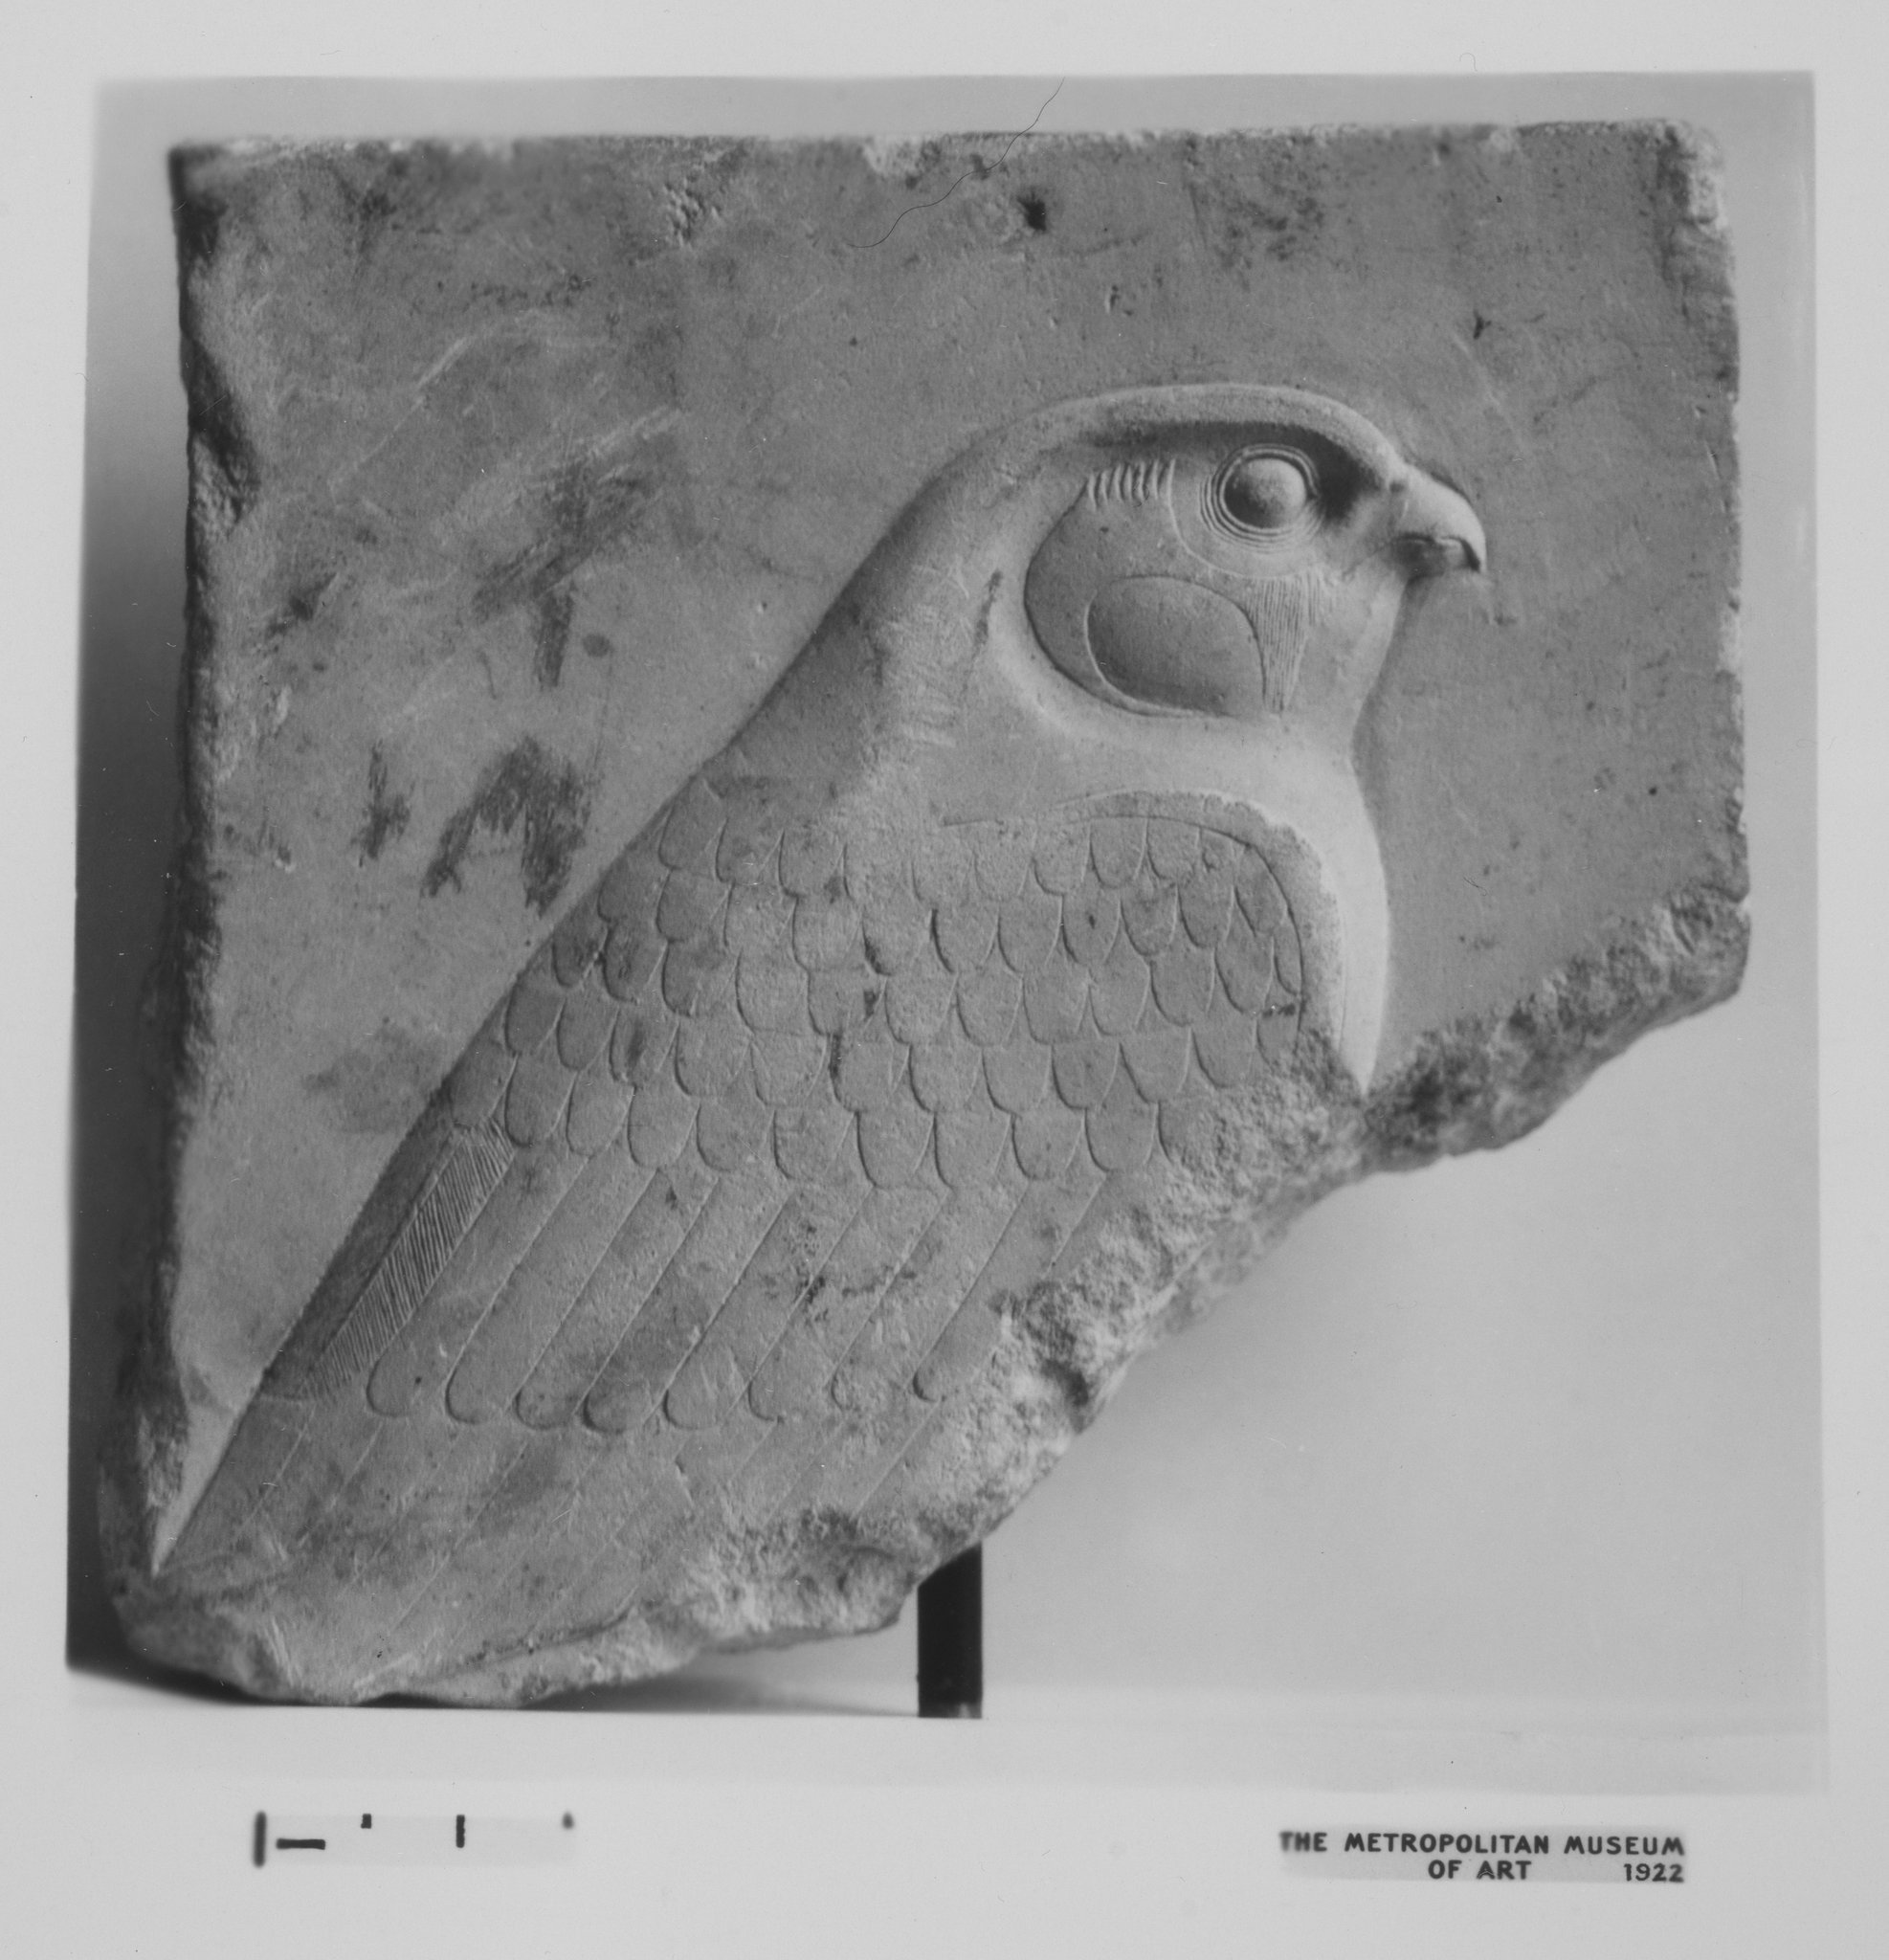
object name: sculptor's model votive, falcon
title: Fragmentary relief plaque with falcon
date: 400-200 BCE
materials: limestone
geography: egypt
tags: falcons